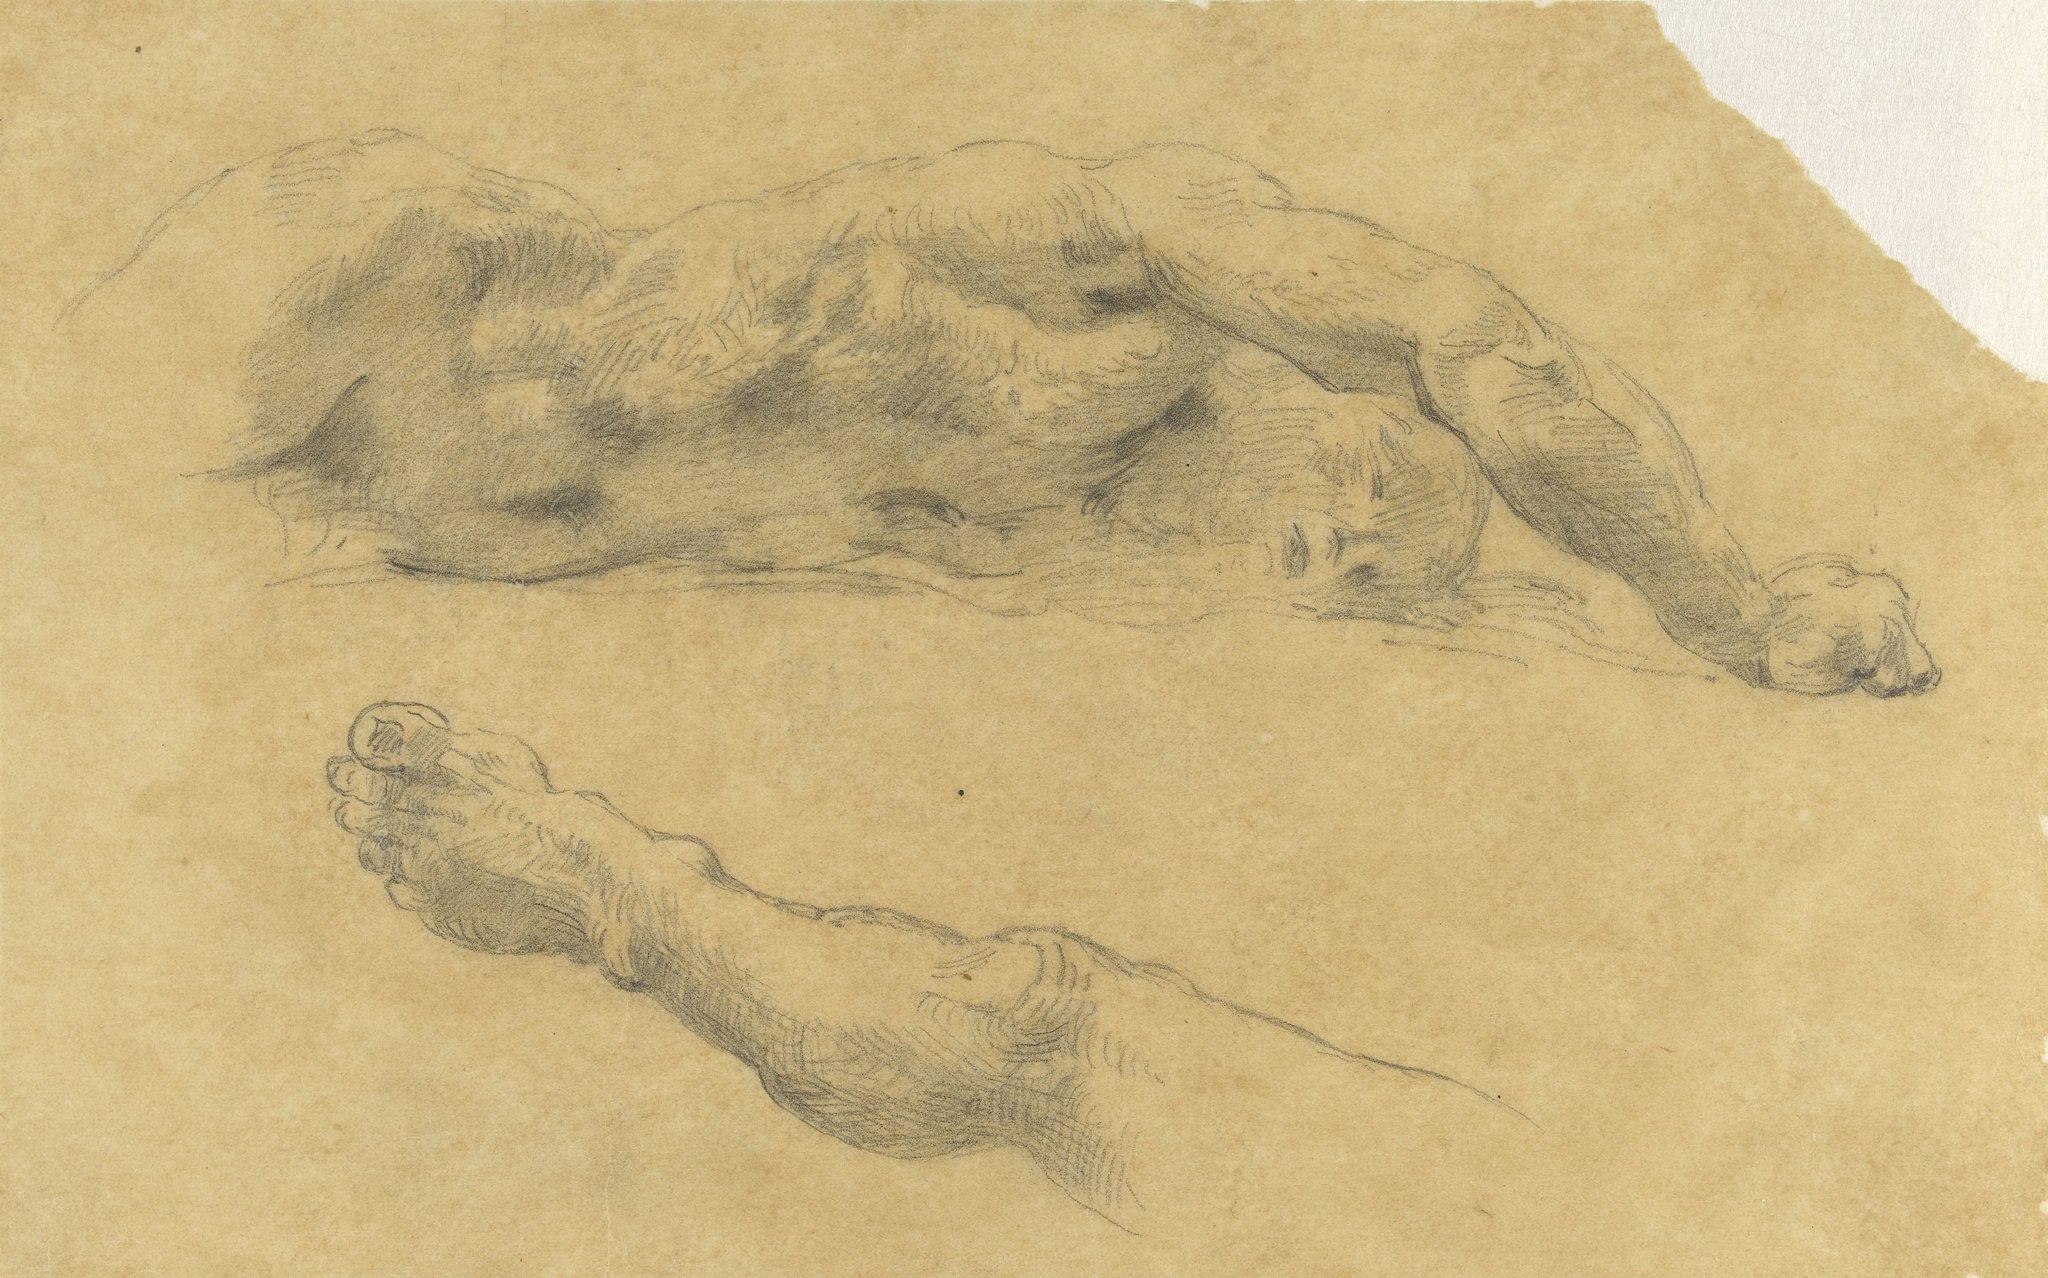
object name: drawing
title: Liggende naakte man; zijn been nog eens afzonderlijk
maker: eugène delacroix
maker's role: draughtsman, print maker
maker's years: 1798-1863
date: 1808-1863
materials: pencil, paper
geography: france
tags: lower leg, lying figure